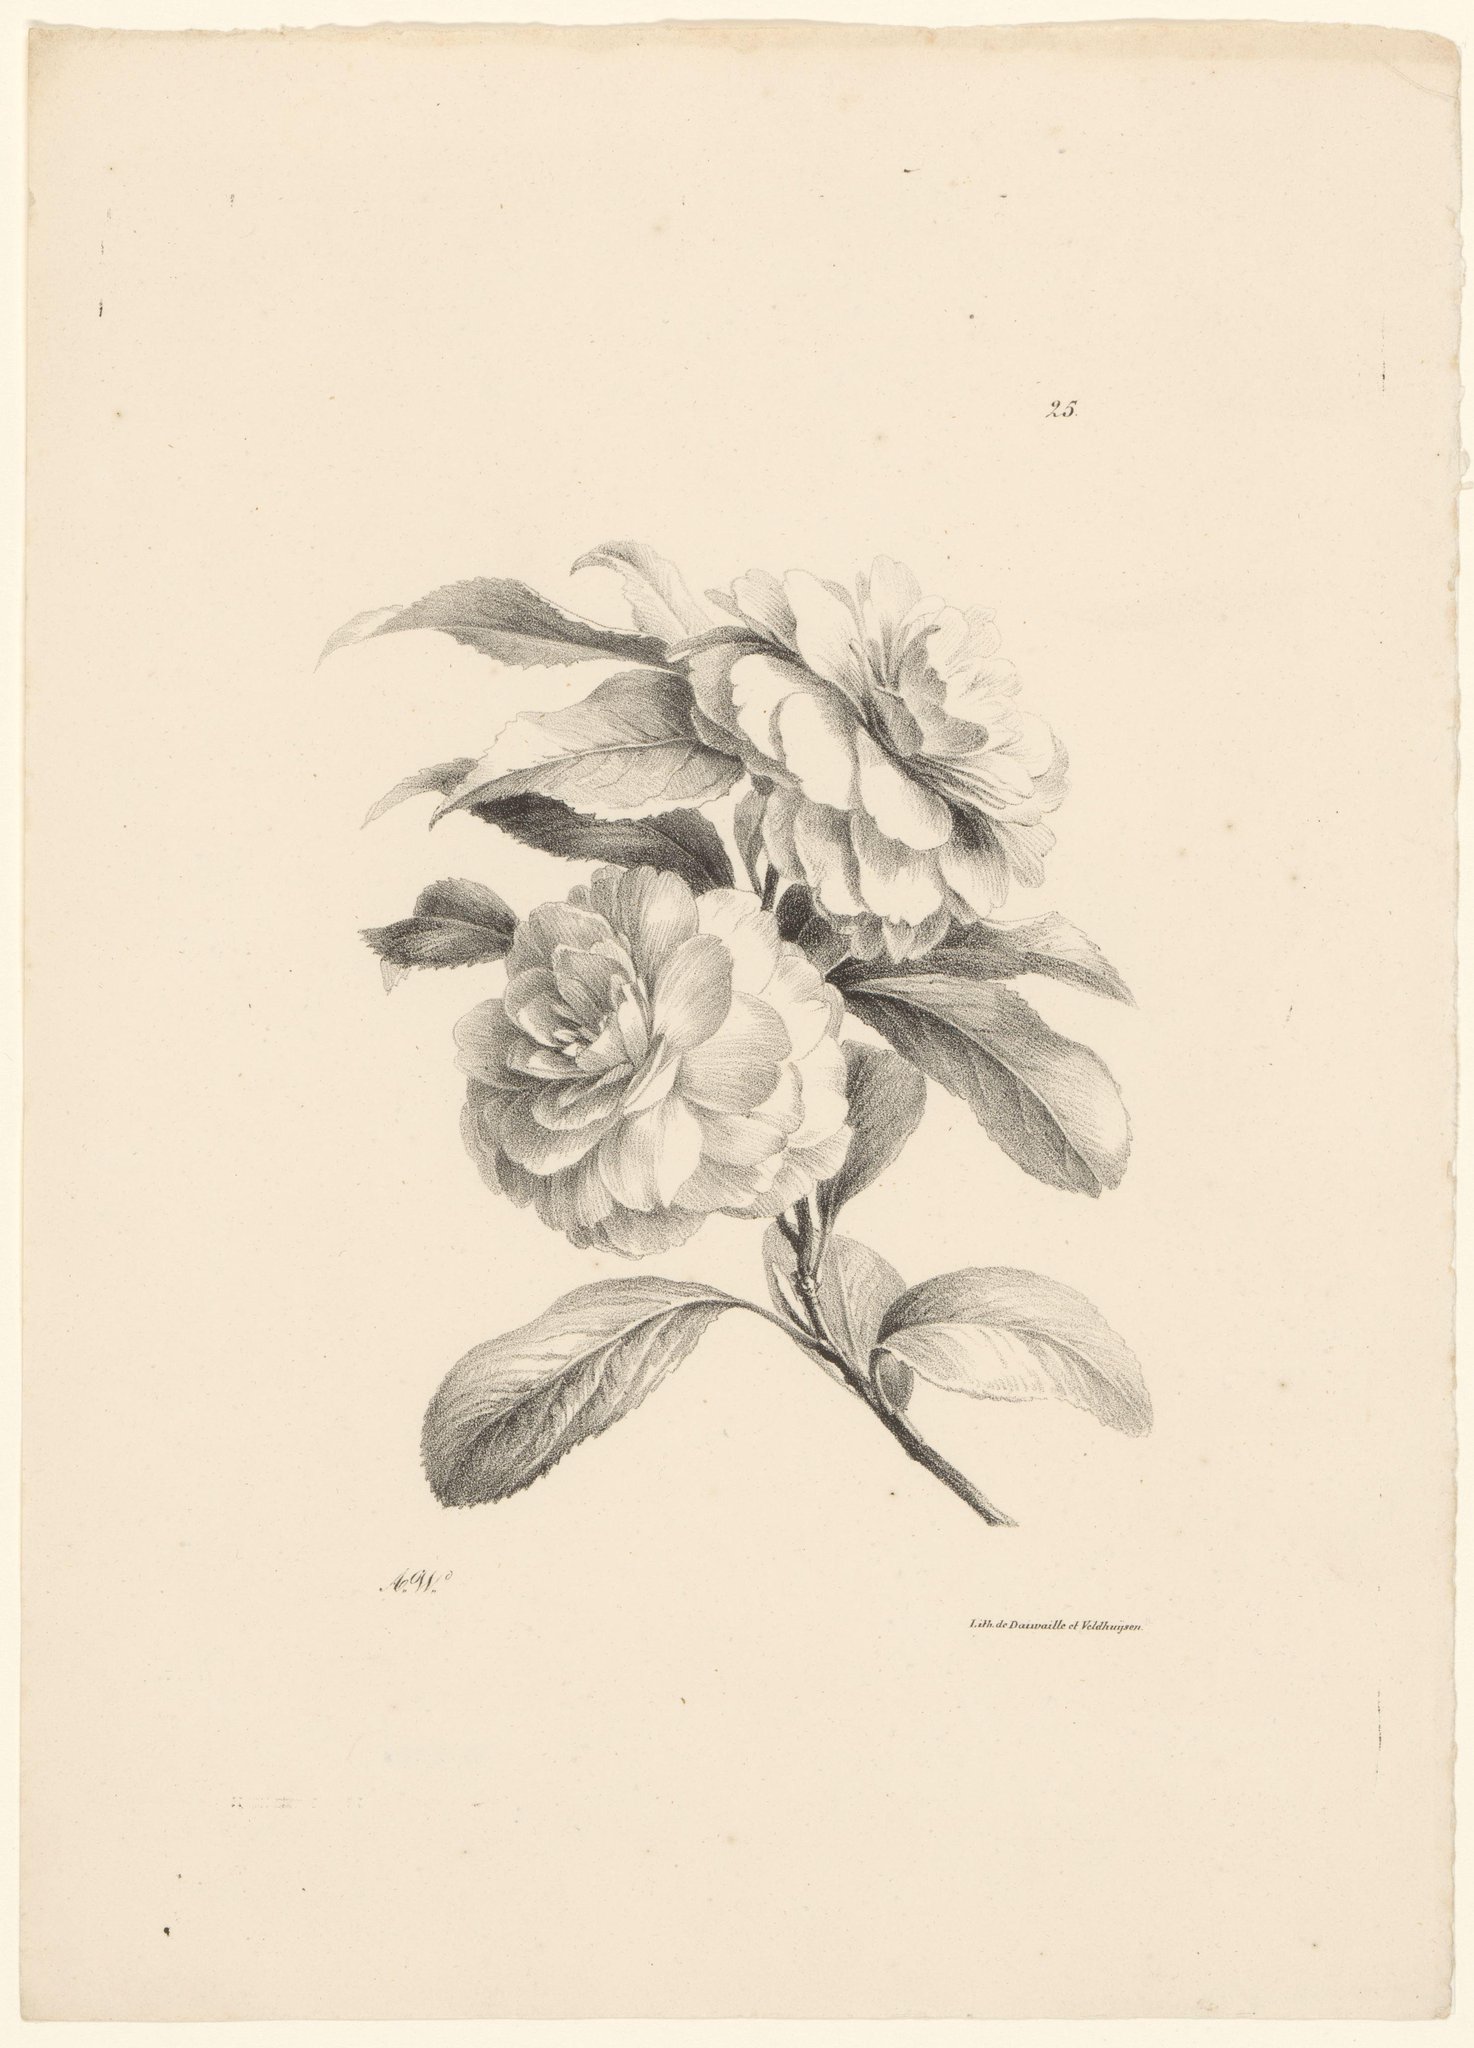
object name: print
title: Bloemen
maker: anton weiss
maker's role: draughtsman, print maker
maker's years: 1801-1851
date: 1831-1832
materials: paper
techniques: lithograph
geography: amsterdam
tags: flowers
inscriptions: watermark